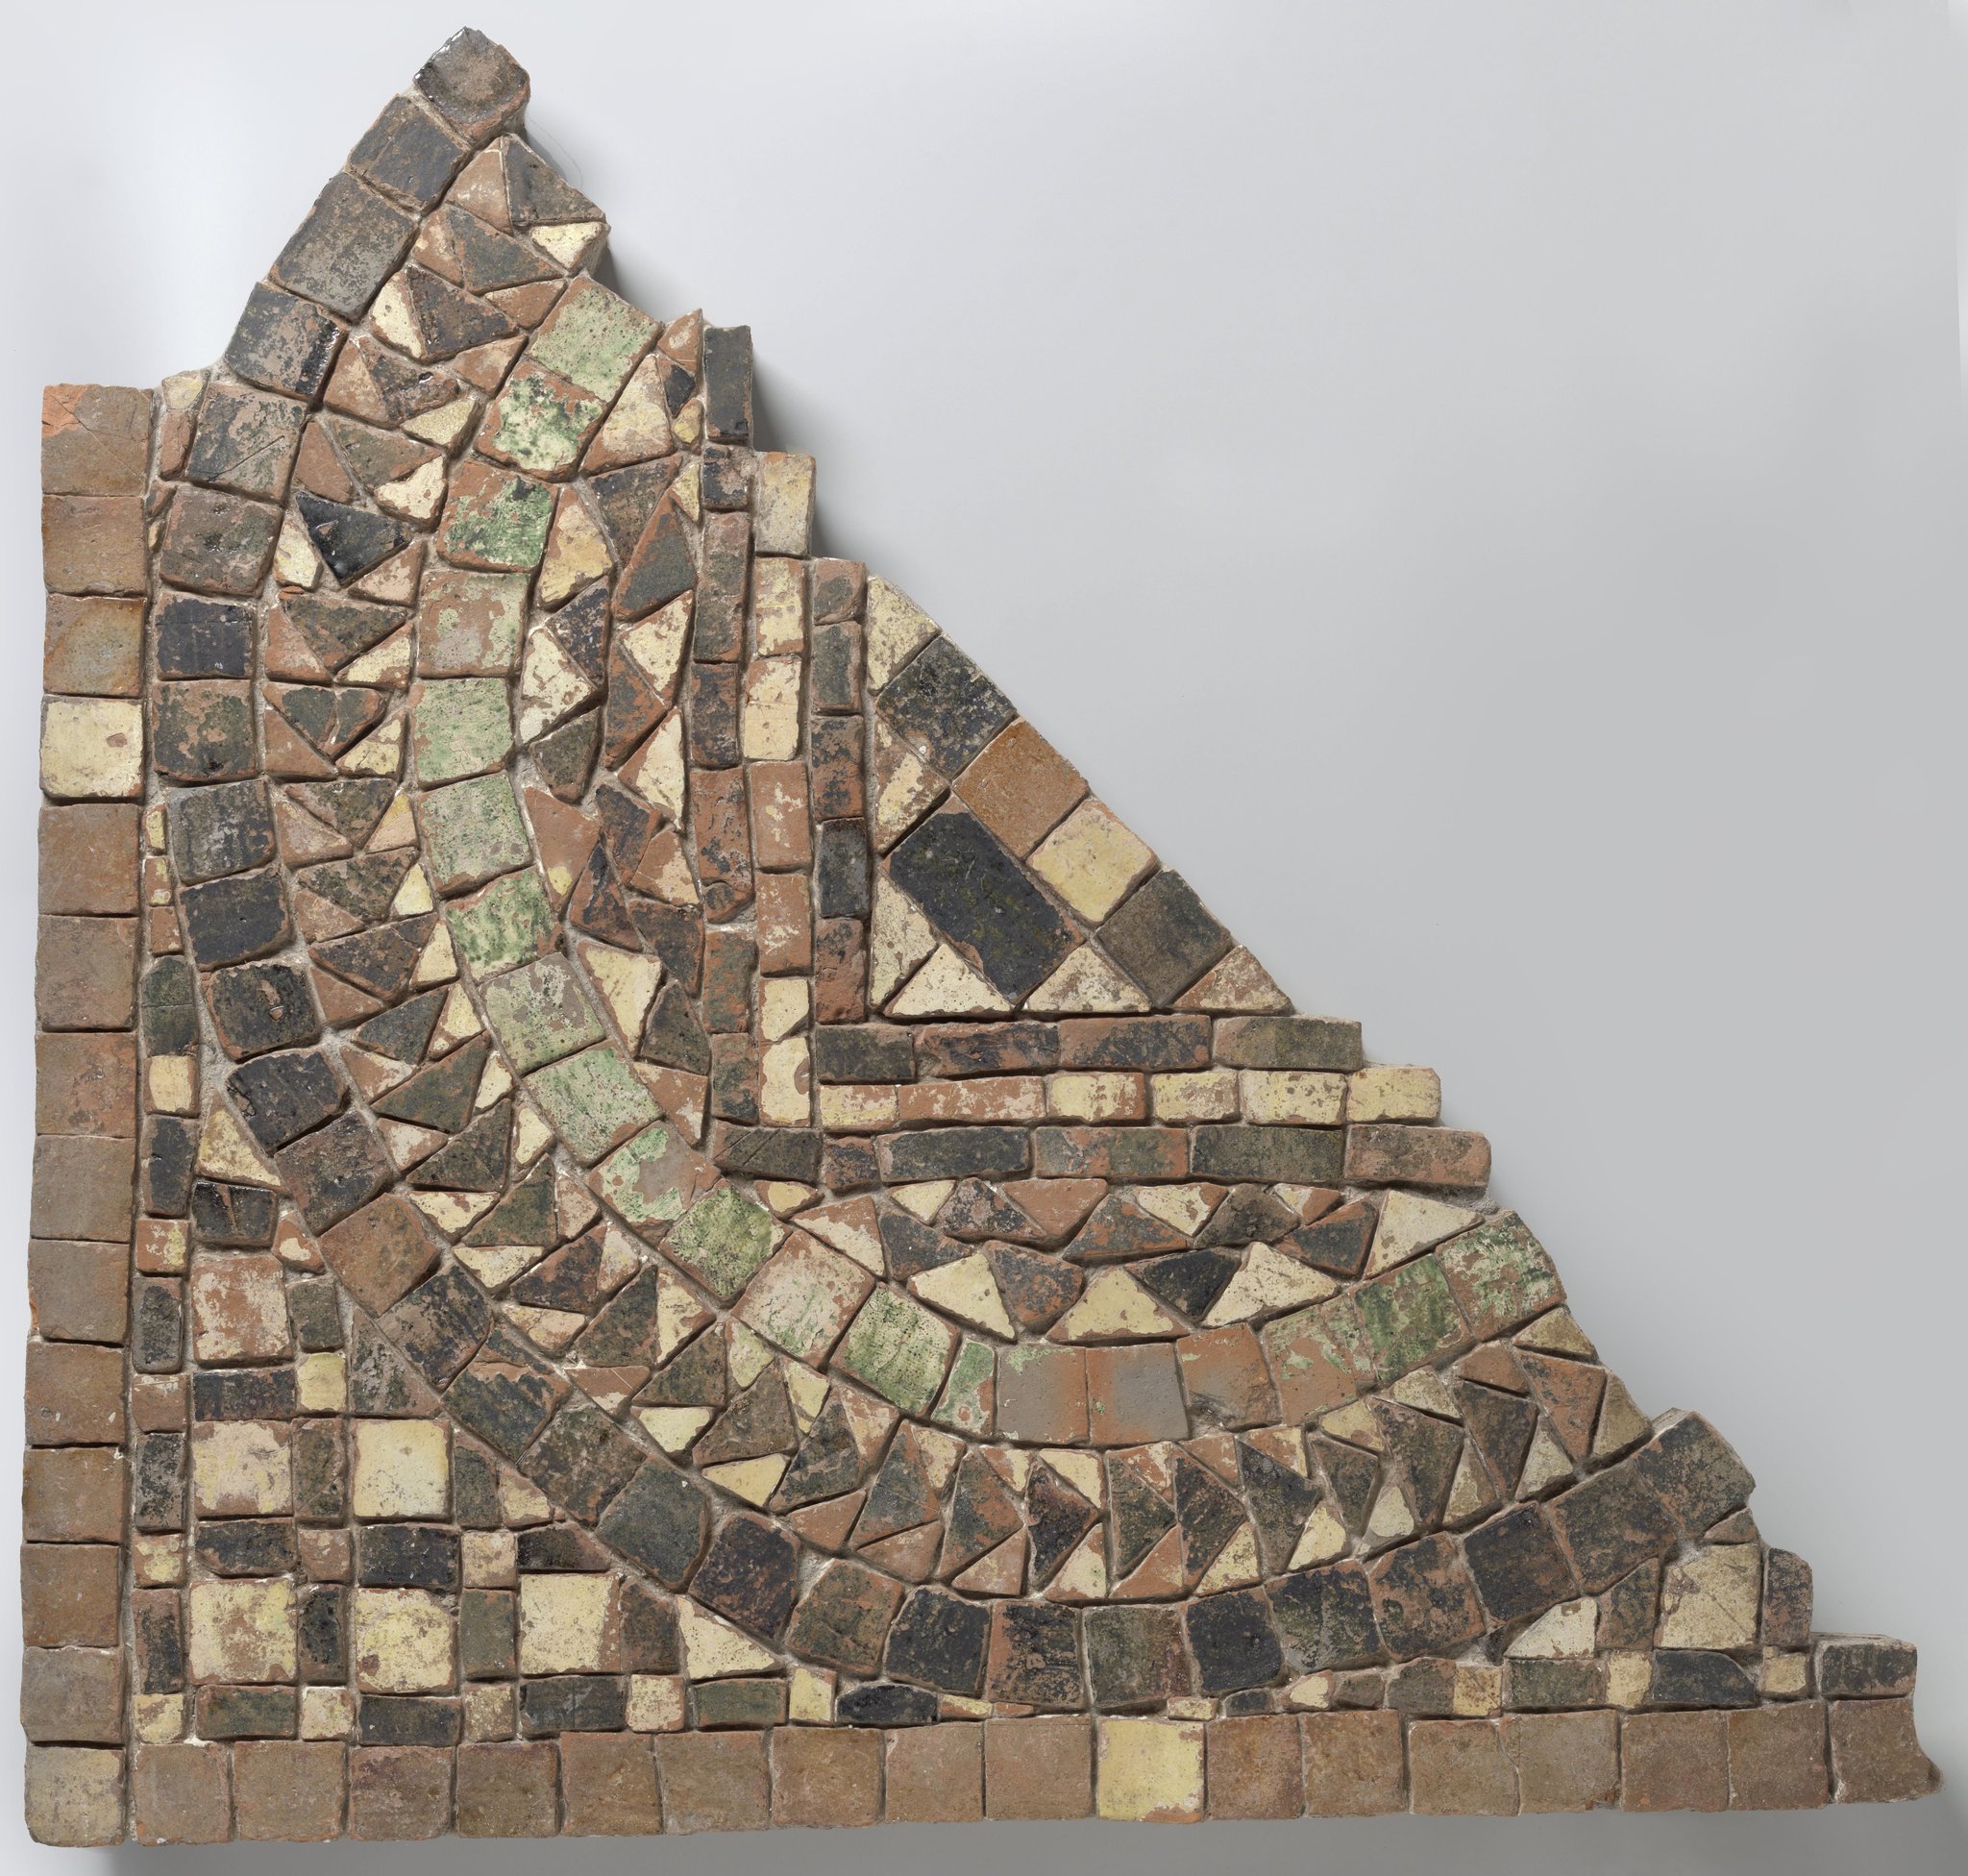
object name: tile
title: Deel van tegelvloer afkomstig uit de Nederlands Hervormde Kerk te Heukelum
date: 1325-1375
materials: ceramic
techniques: vitrification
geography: utrecht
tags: heukelum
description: Driehoekig deel van vloer bestaand uit geglazuurde tegels in de kleuren zwart, groen, rood en geel. De tegels zijn geplakt op een dikke plaat.